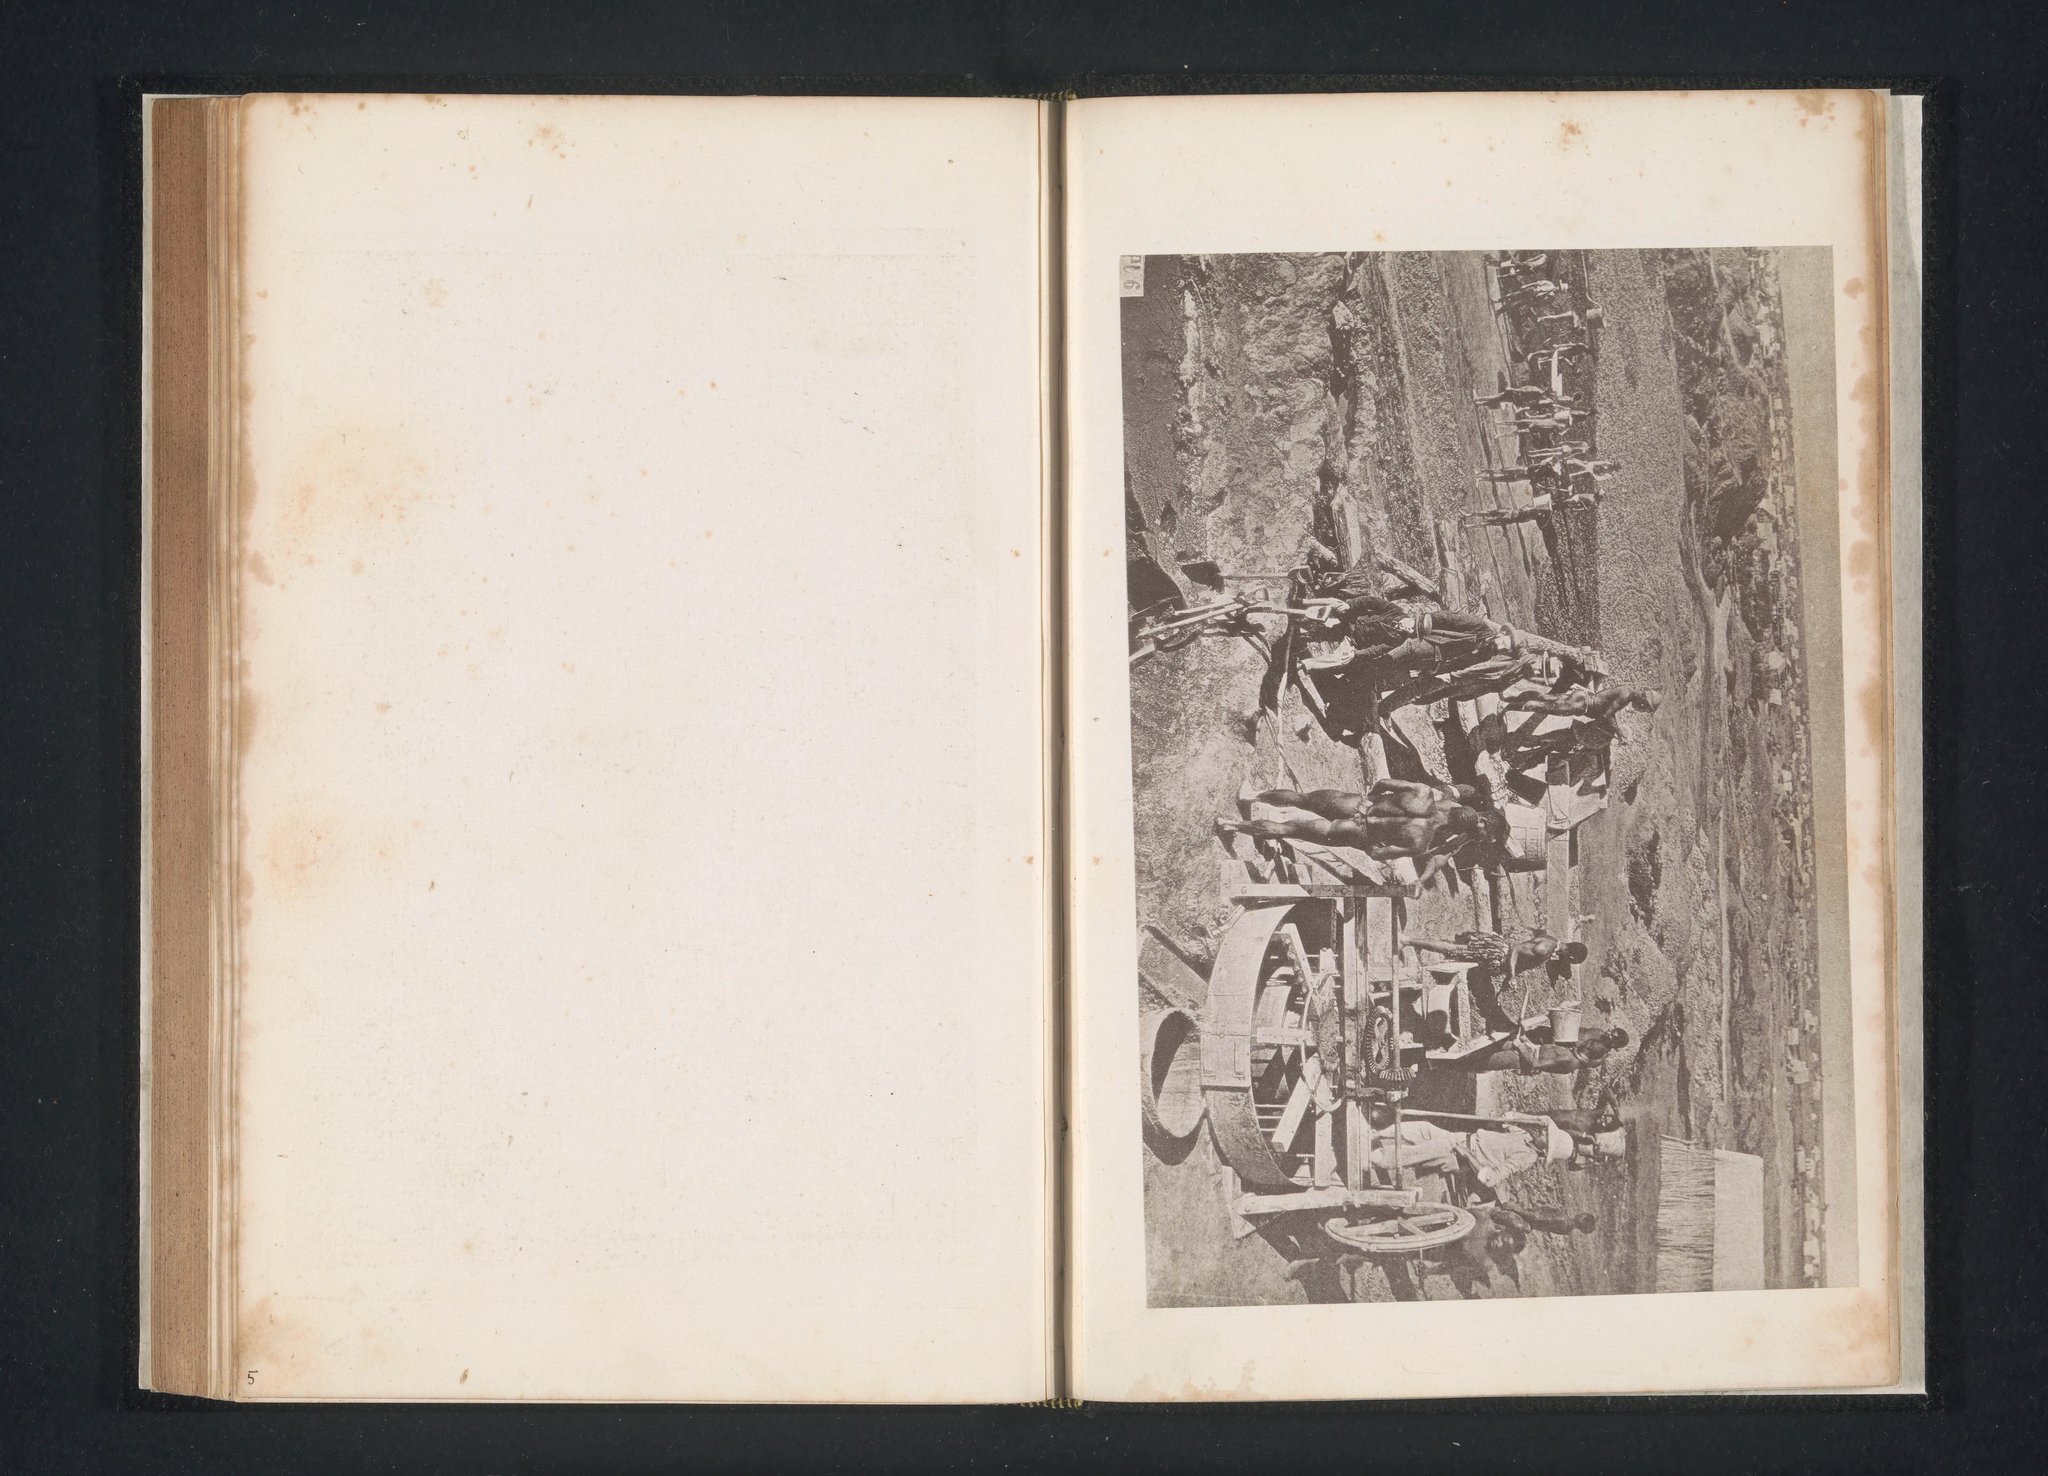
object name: photomechanical print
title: Mannen aan het werk in een diamantmijn in Zuid-Afrika, vermoedelijk bij Kimberley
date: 1870-1880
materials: paper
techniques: photograph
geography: south africa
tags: mine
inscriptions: number: ‘Pl. 6’